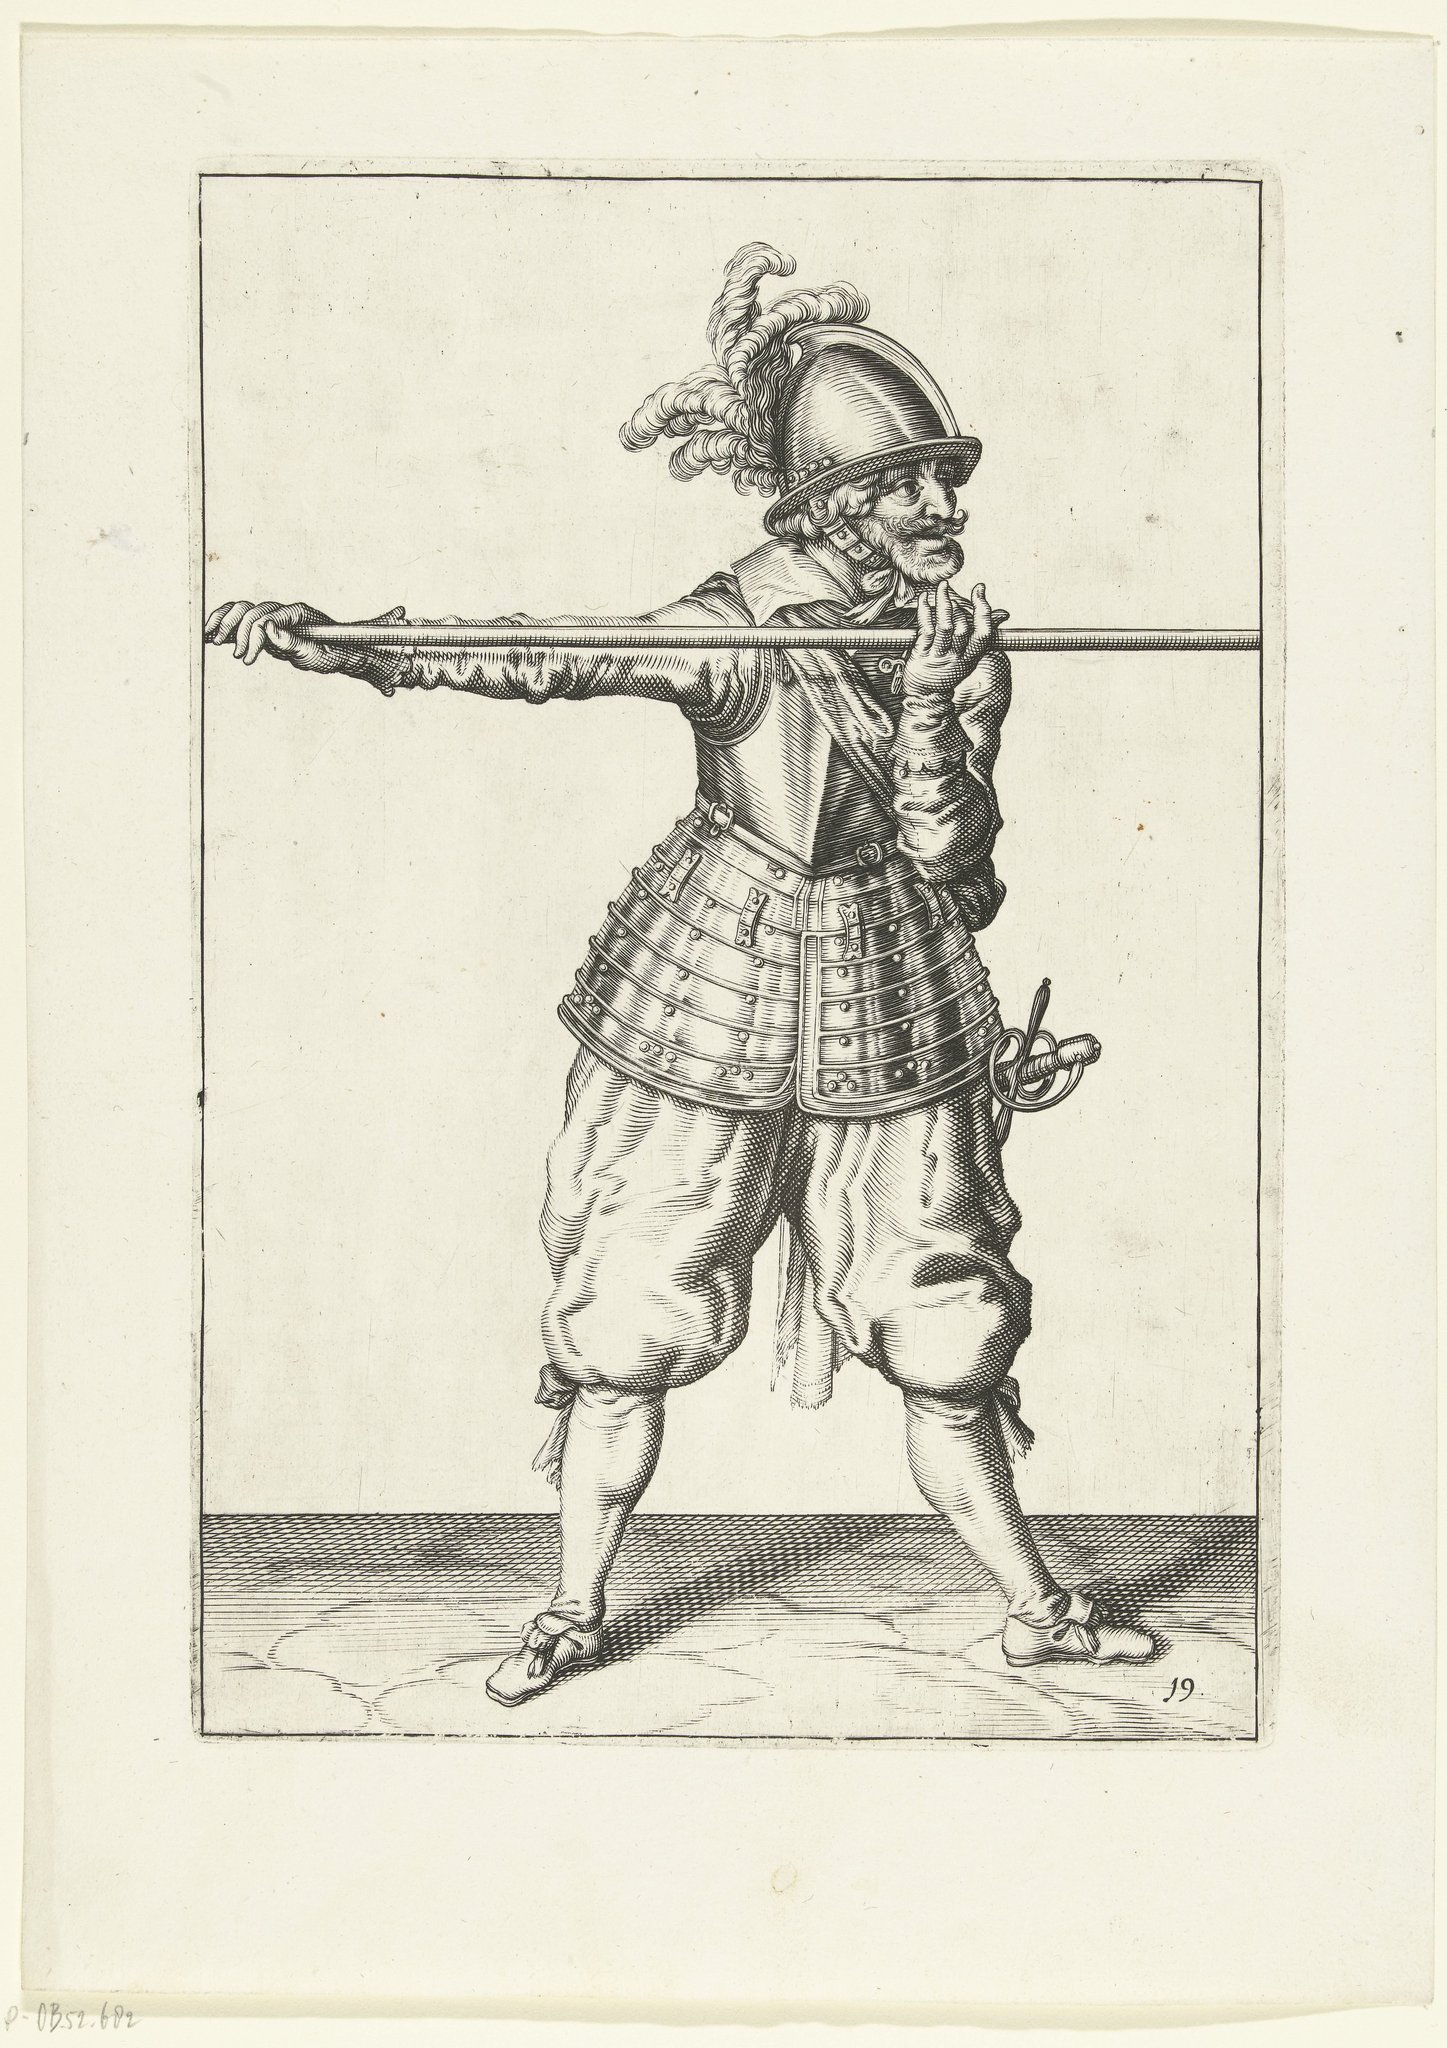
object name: print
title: Wapenhandelinghe van Roers Musquetten ende Spiessen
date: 1597-1607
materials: paper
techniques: engraving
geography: netherlands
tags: manoeuvre ~ military training, warfare; military affairs (+ mercenary troops, e.g.: lansquenets), helved weapons, polearms (for striking, hacking, thrusting): lance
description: Een soldaat, ten voeten uit, die een spies (lans) met beide handen horizontaal op schouderhoogte draagt. Deze prent is onderdeel van de reeks van 32 genummerde prenten van spiesdragers uit de Wapenhandelinghe.